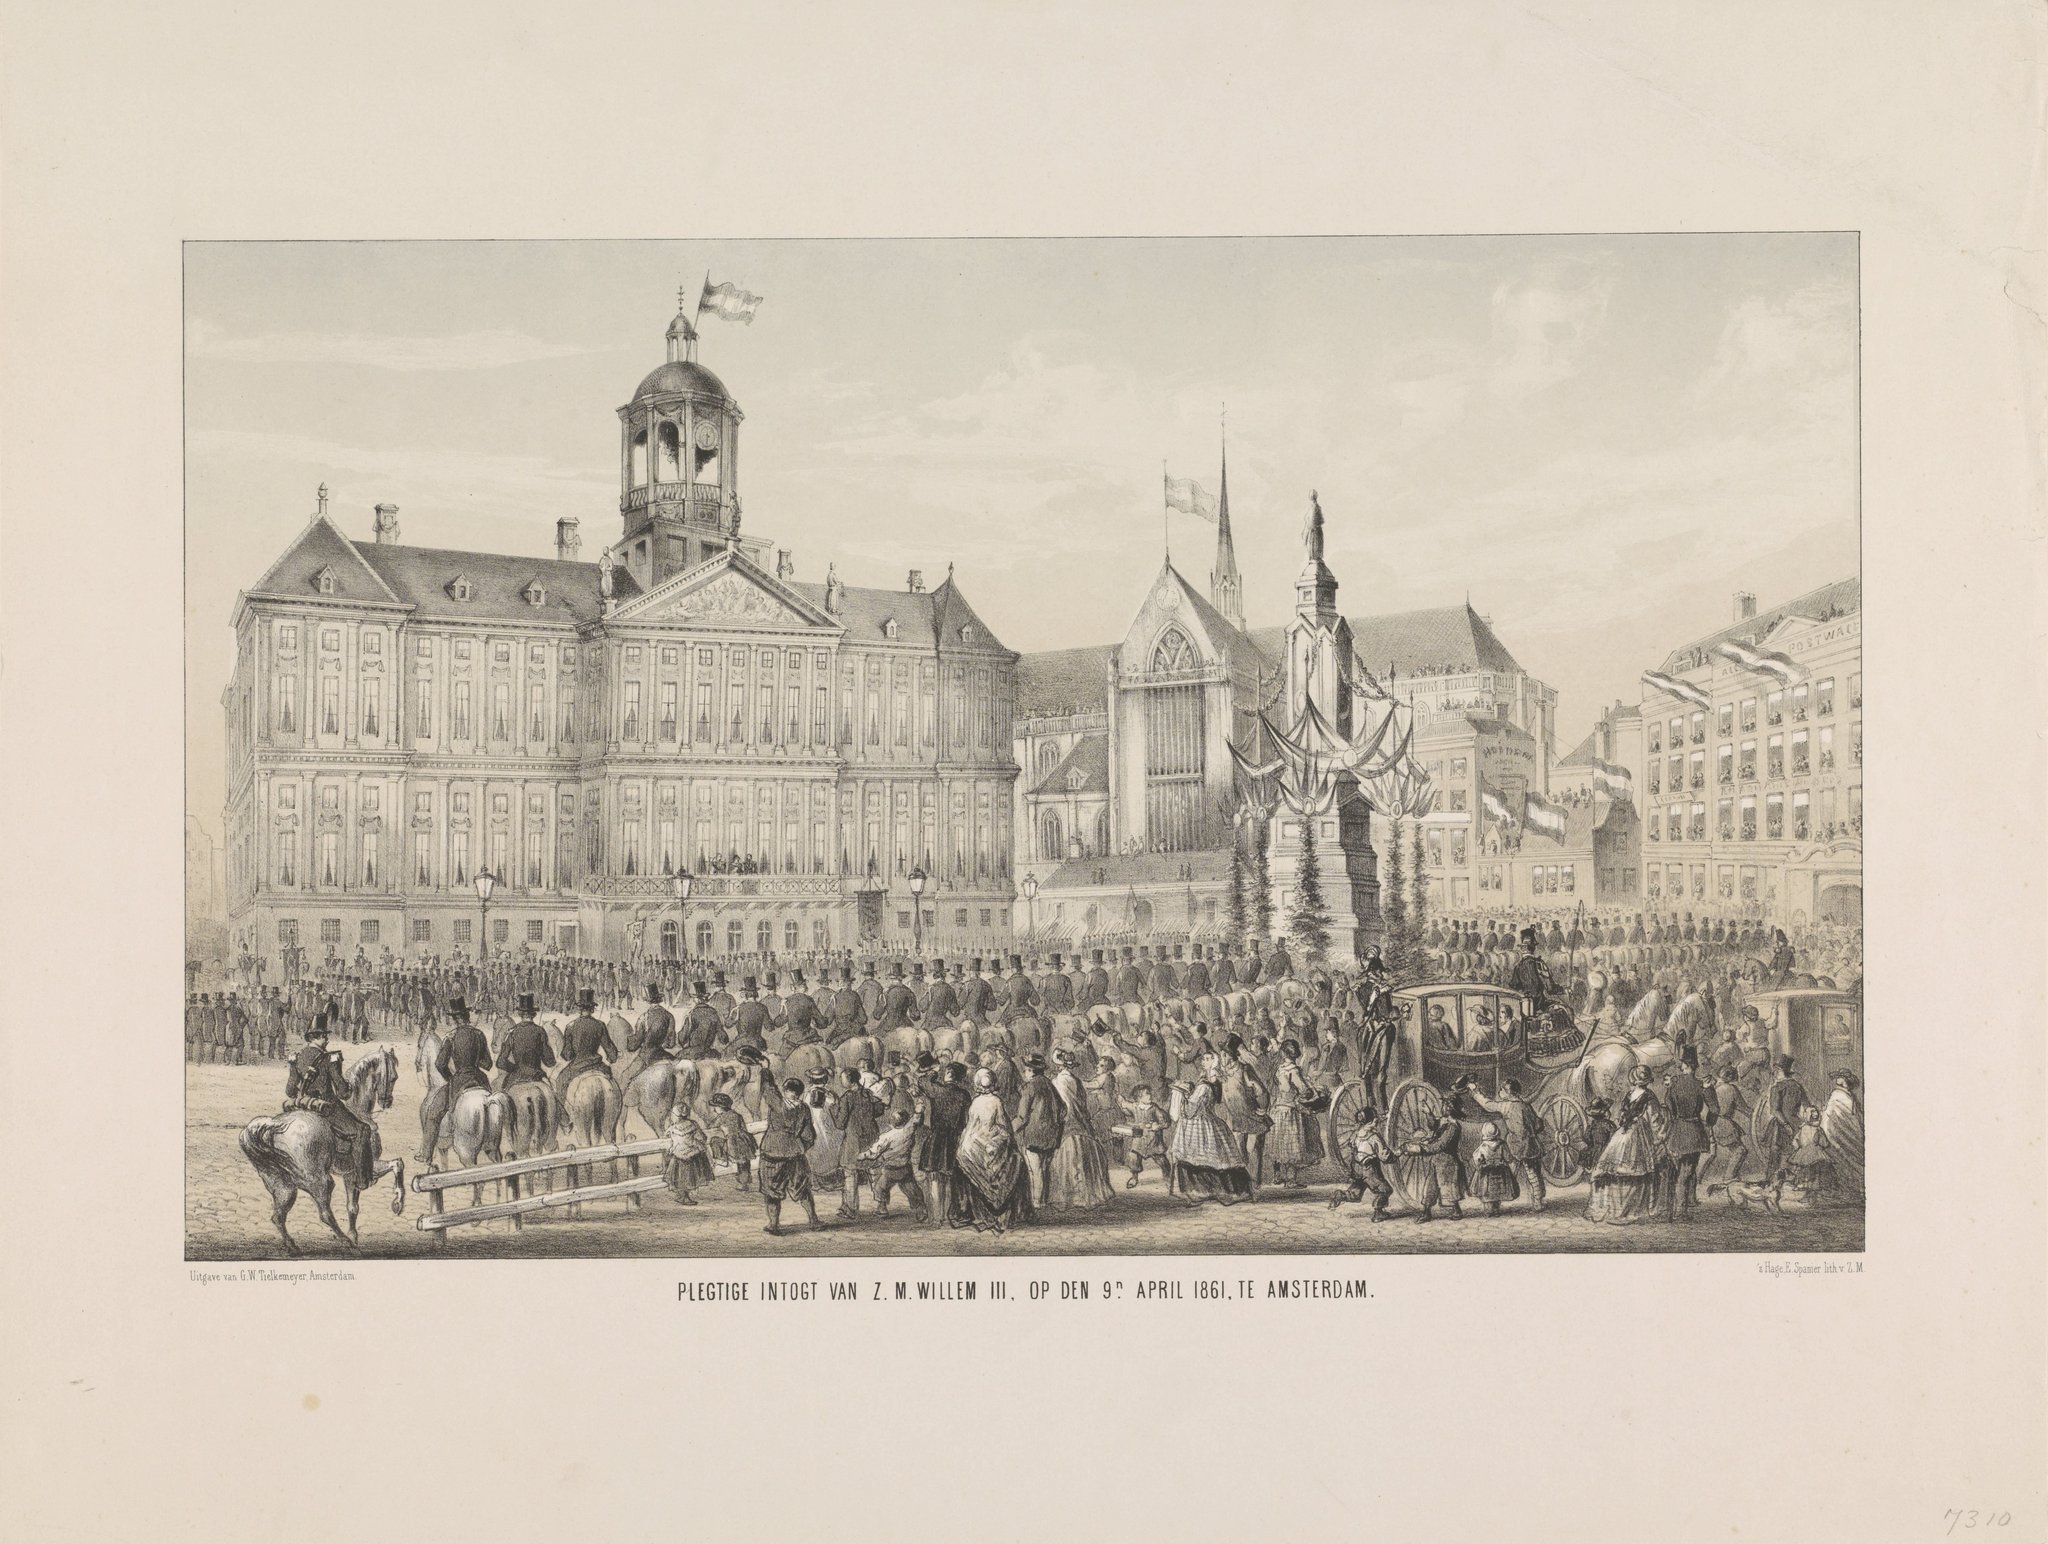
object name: print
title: Plegtige intogt van Z.M. Willem III, op den 9.n april 1861, te Amsterdam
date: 1861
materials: paper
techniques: tone lithography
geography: netherlands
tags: brussels, willem iii (koning der nederlanden), public festivities on the occasion of royal events, military parade, pageant, royal palace of amsterdam, amsterdam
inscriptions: collector's mark: Lugt 2228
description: Defilé voor het Koninklijk Paleis op de Dam te Amsterdam op 9 april 1861. De Koninklijke familie staat op het balkon van het paleis. Op de voorgrond een erewacht te paard, voor het paleis marcheren troepen.